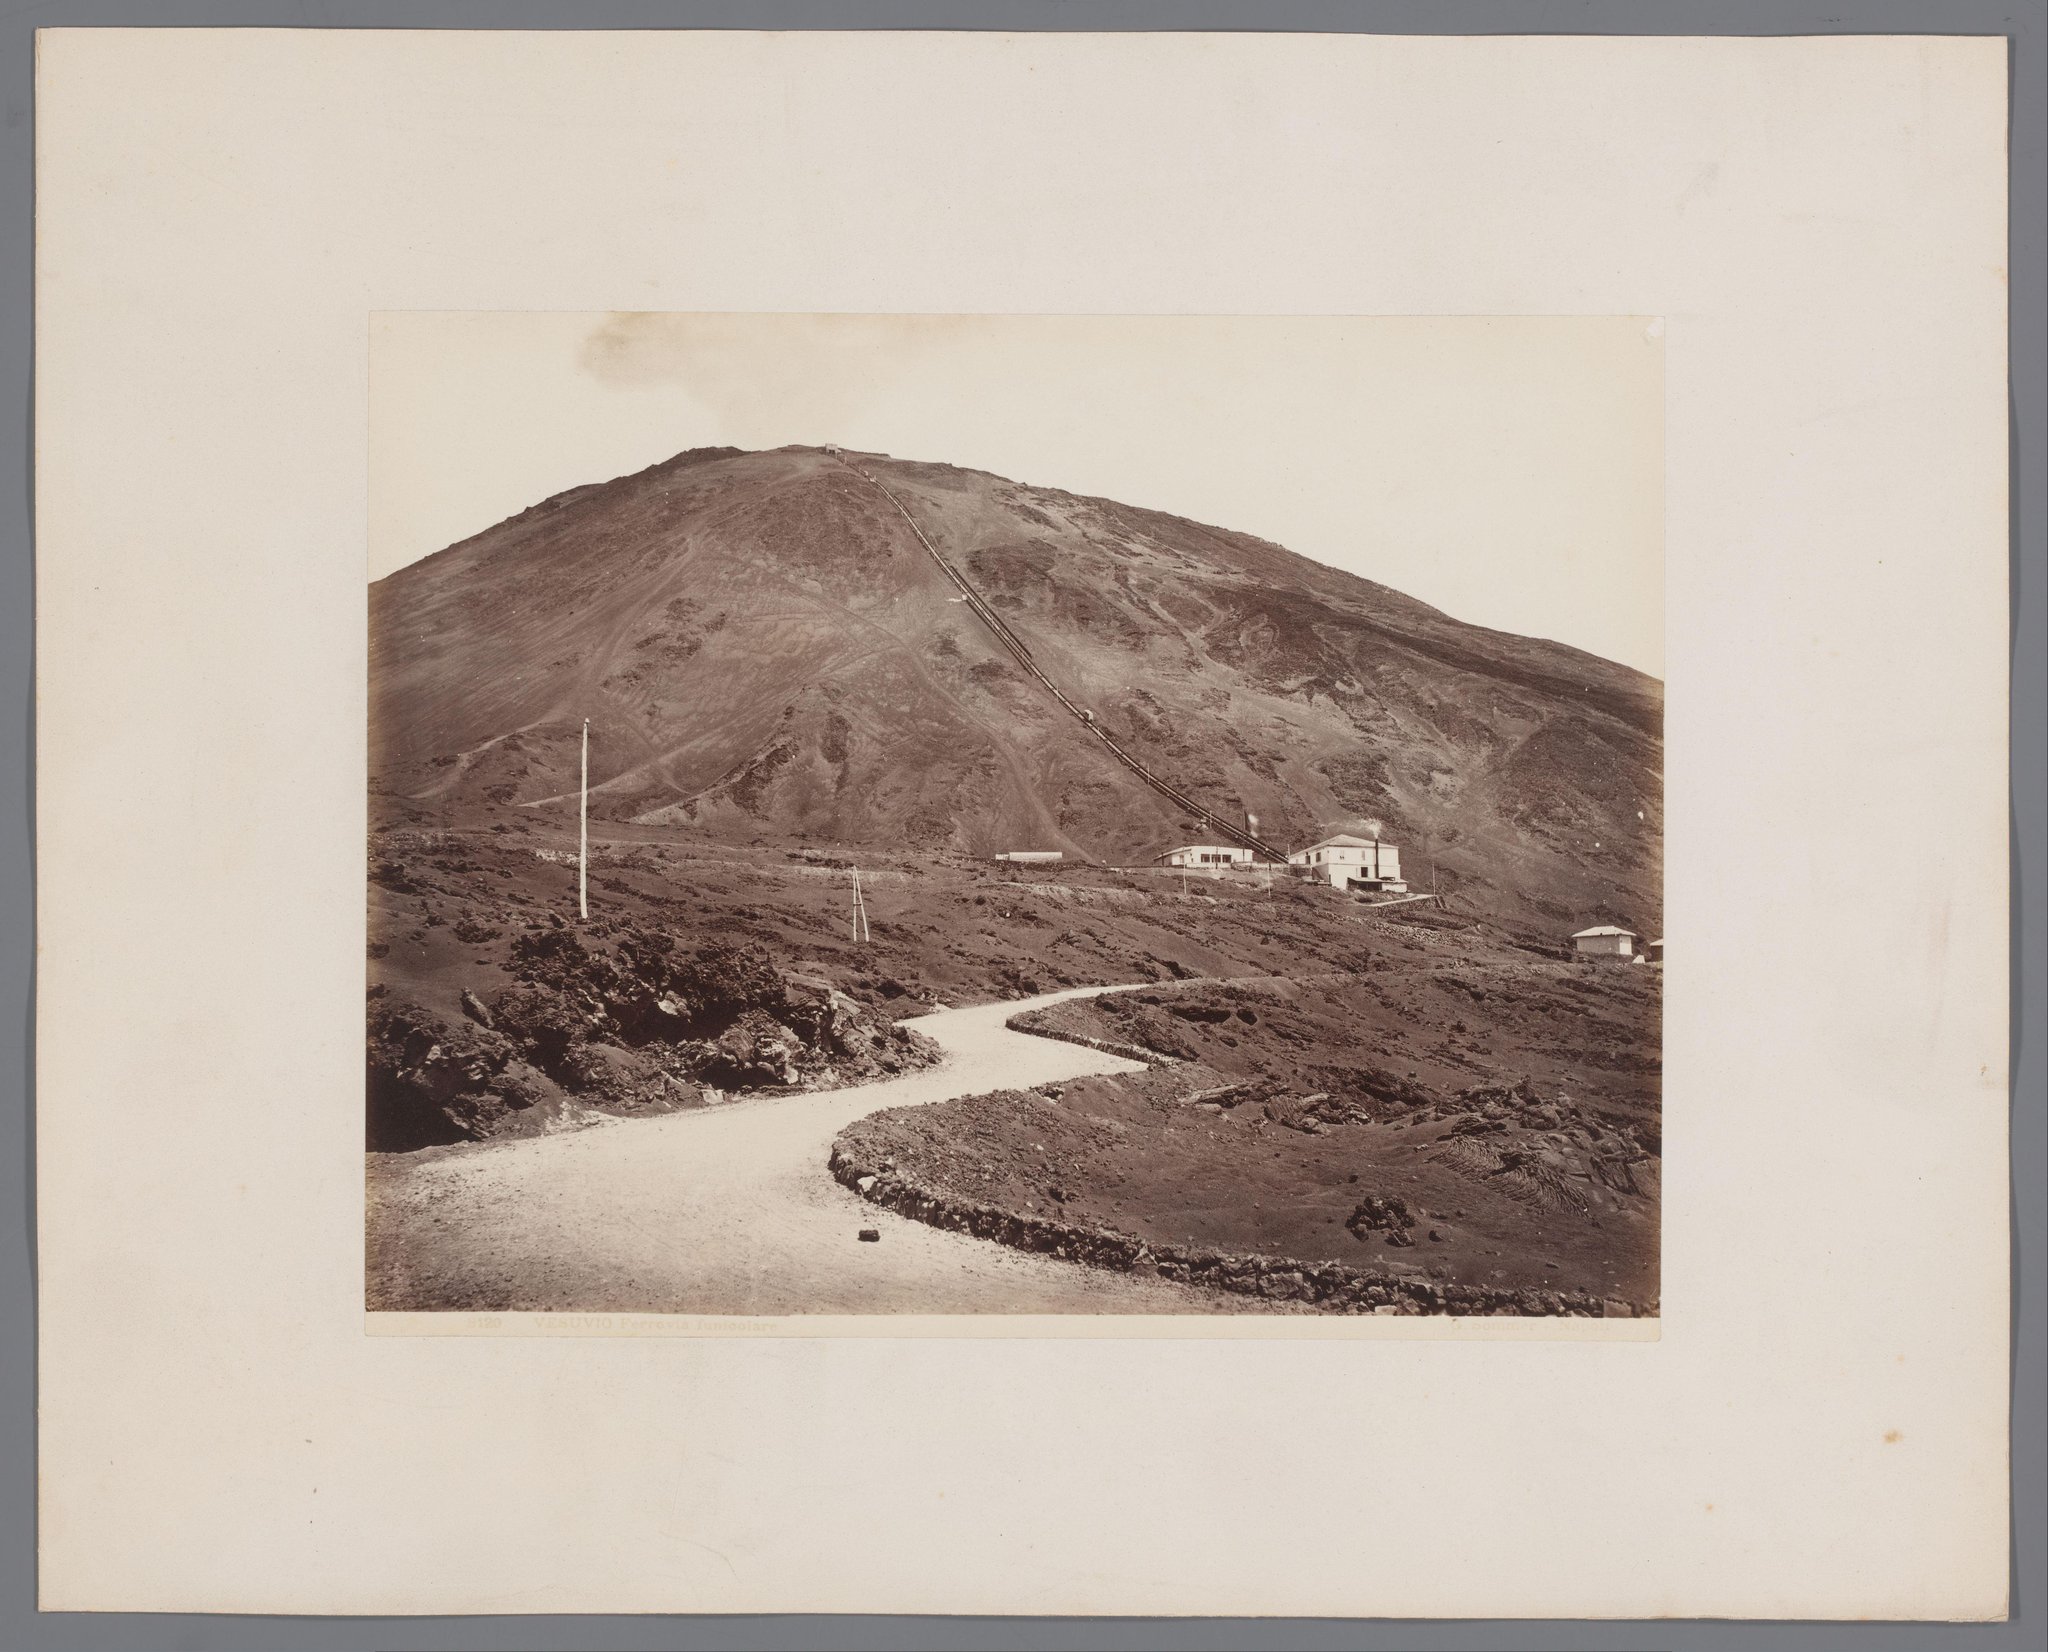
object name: photograph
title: Ferrovia funicolare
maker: giorgio sommer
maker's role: fotograaf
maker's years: 1834-1914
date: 1857-1914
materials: cardboard, paper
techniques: albumen print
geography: pompeii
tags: rack railway, volcano, mount vesuvius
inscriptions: number: ‘8120’